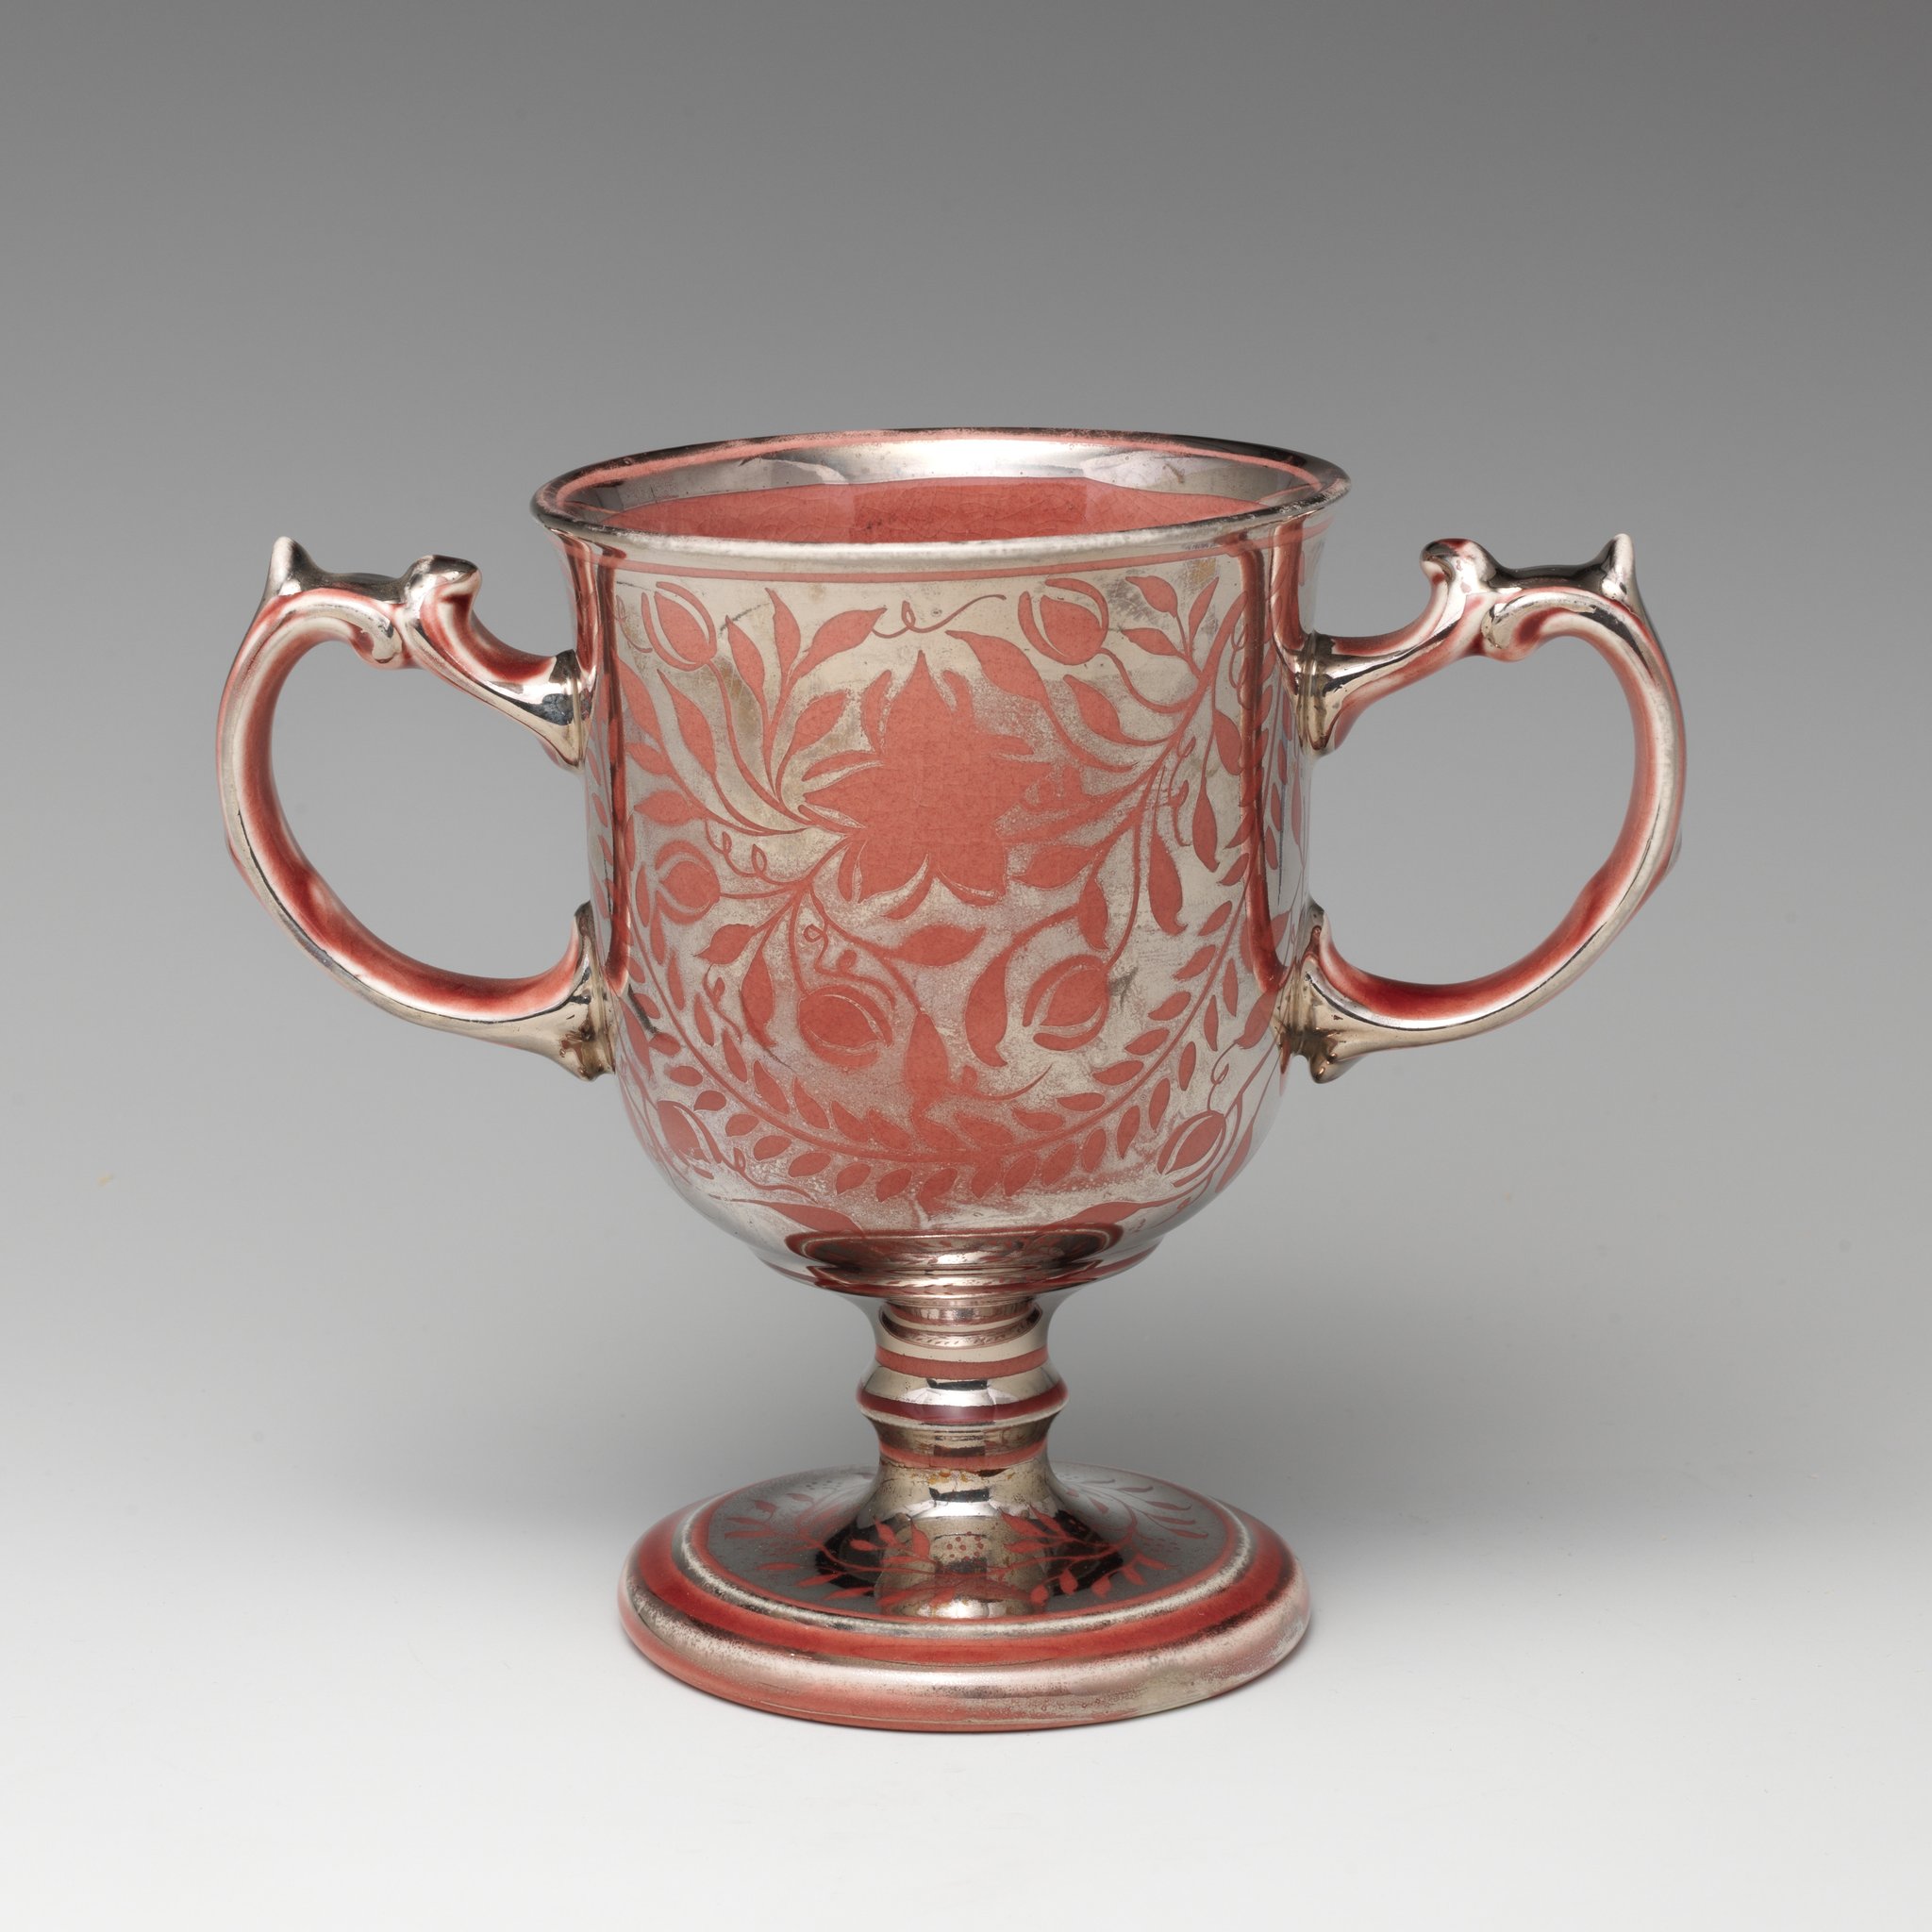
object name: goblet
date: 1800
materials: earthenware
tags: flowers